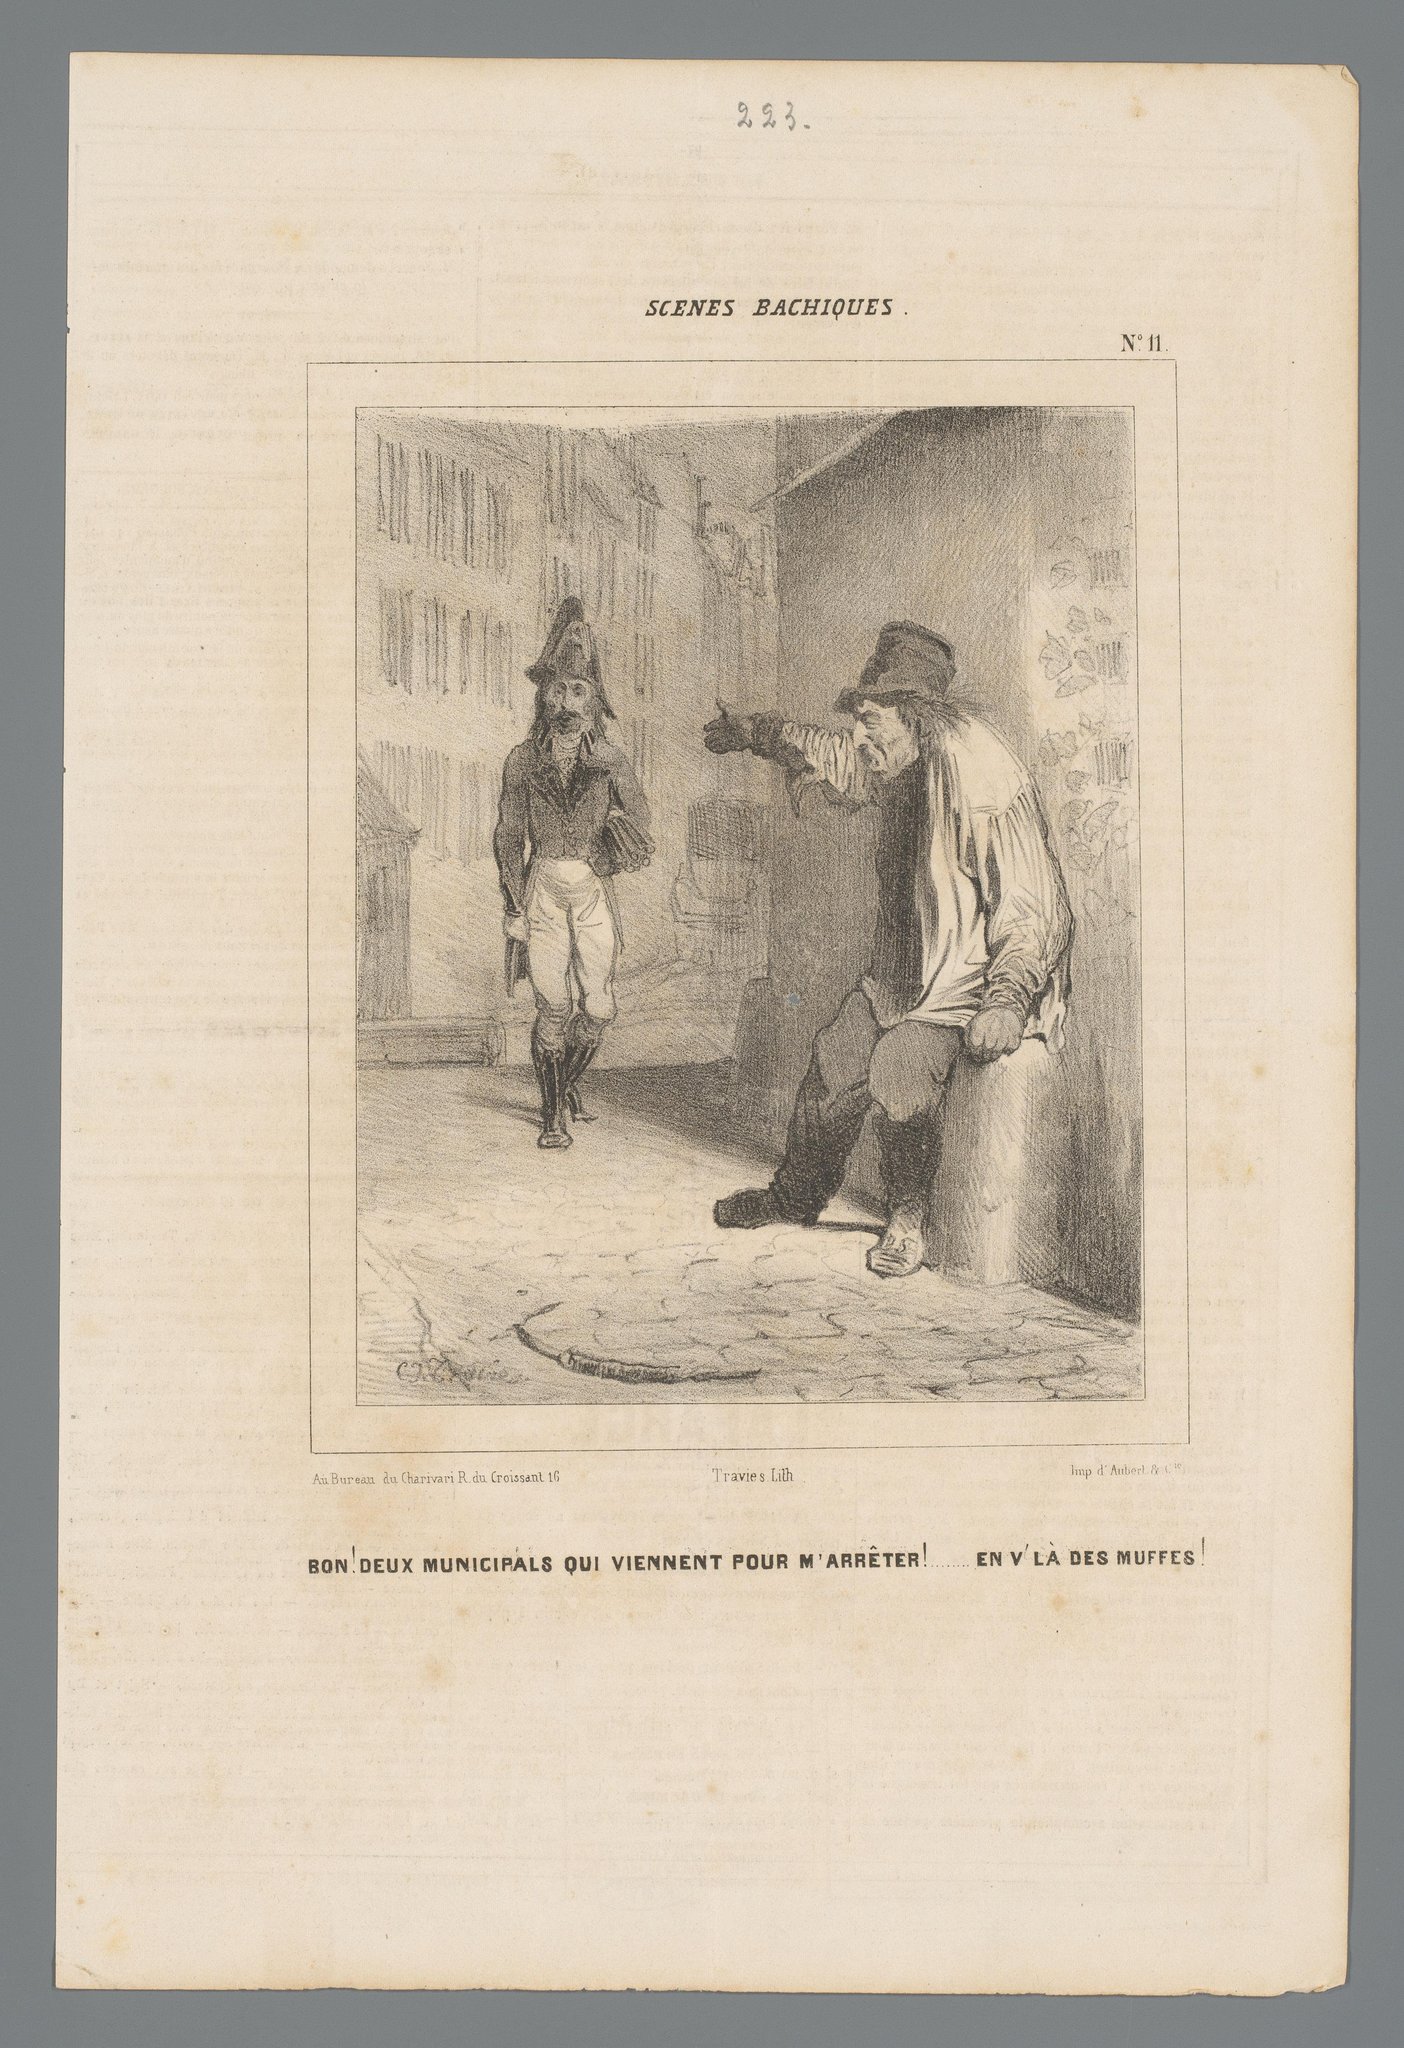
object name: print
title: Dronkemansscènes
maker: charles-joseph traviès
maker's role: print maker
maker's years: 1804-1859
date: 1839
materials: paper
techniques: letterpress printing, lithograph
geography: paris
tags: alcoholism, street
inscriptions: collector's mark: Lugt 2228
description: Prent uit: Le Charivari 8 (1839), nr. 292, 19 oktober 1839.